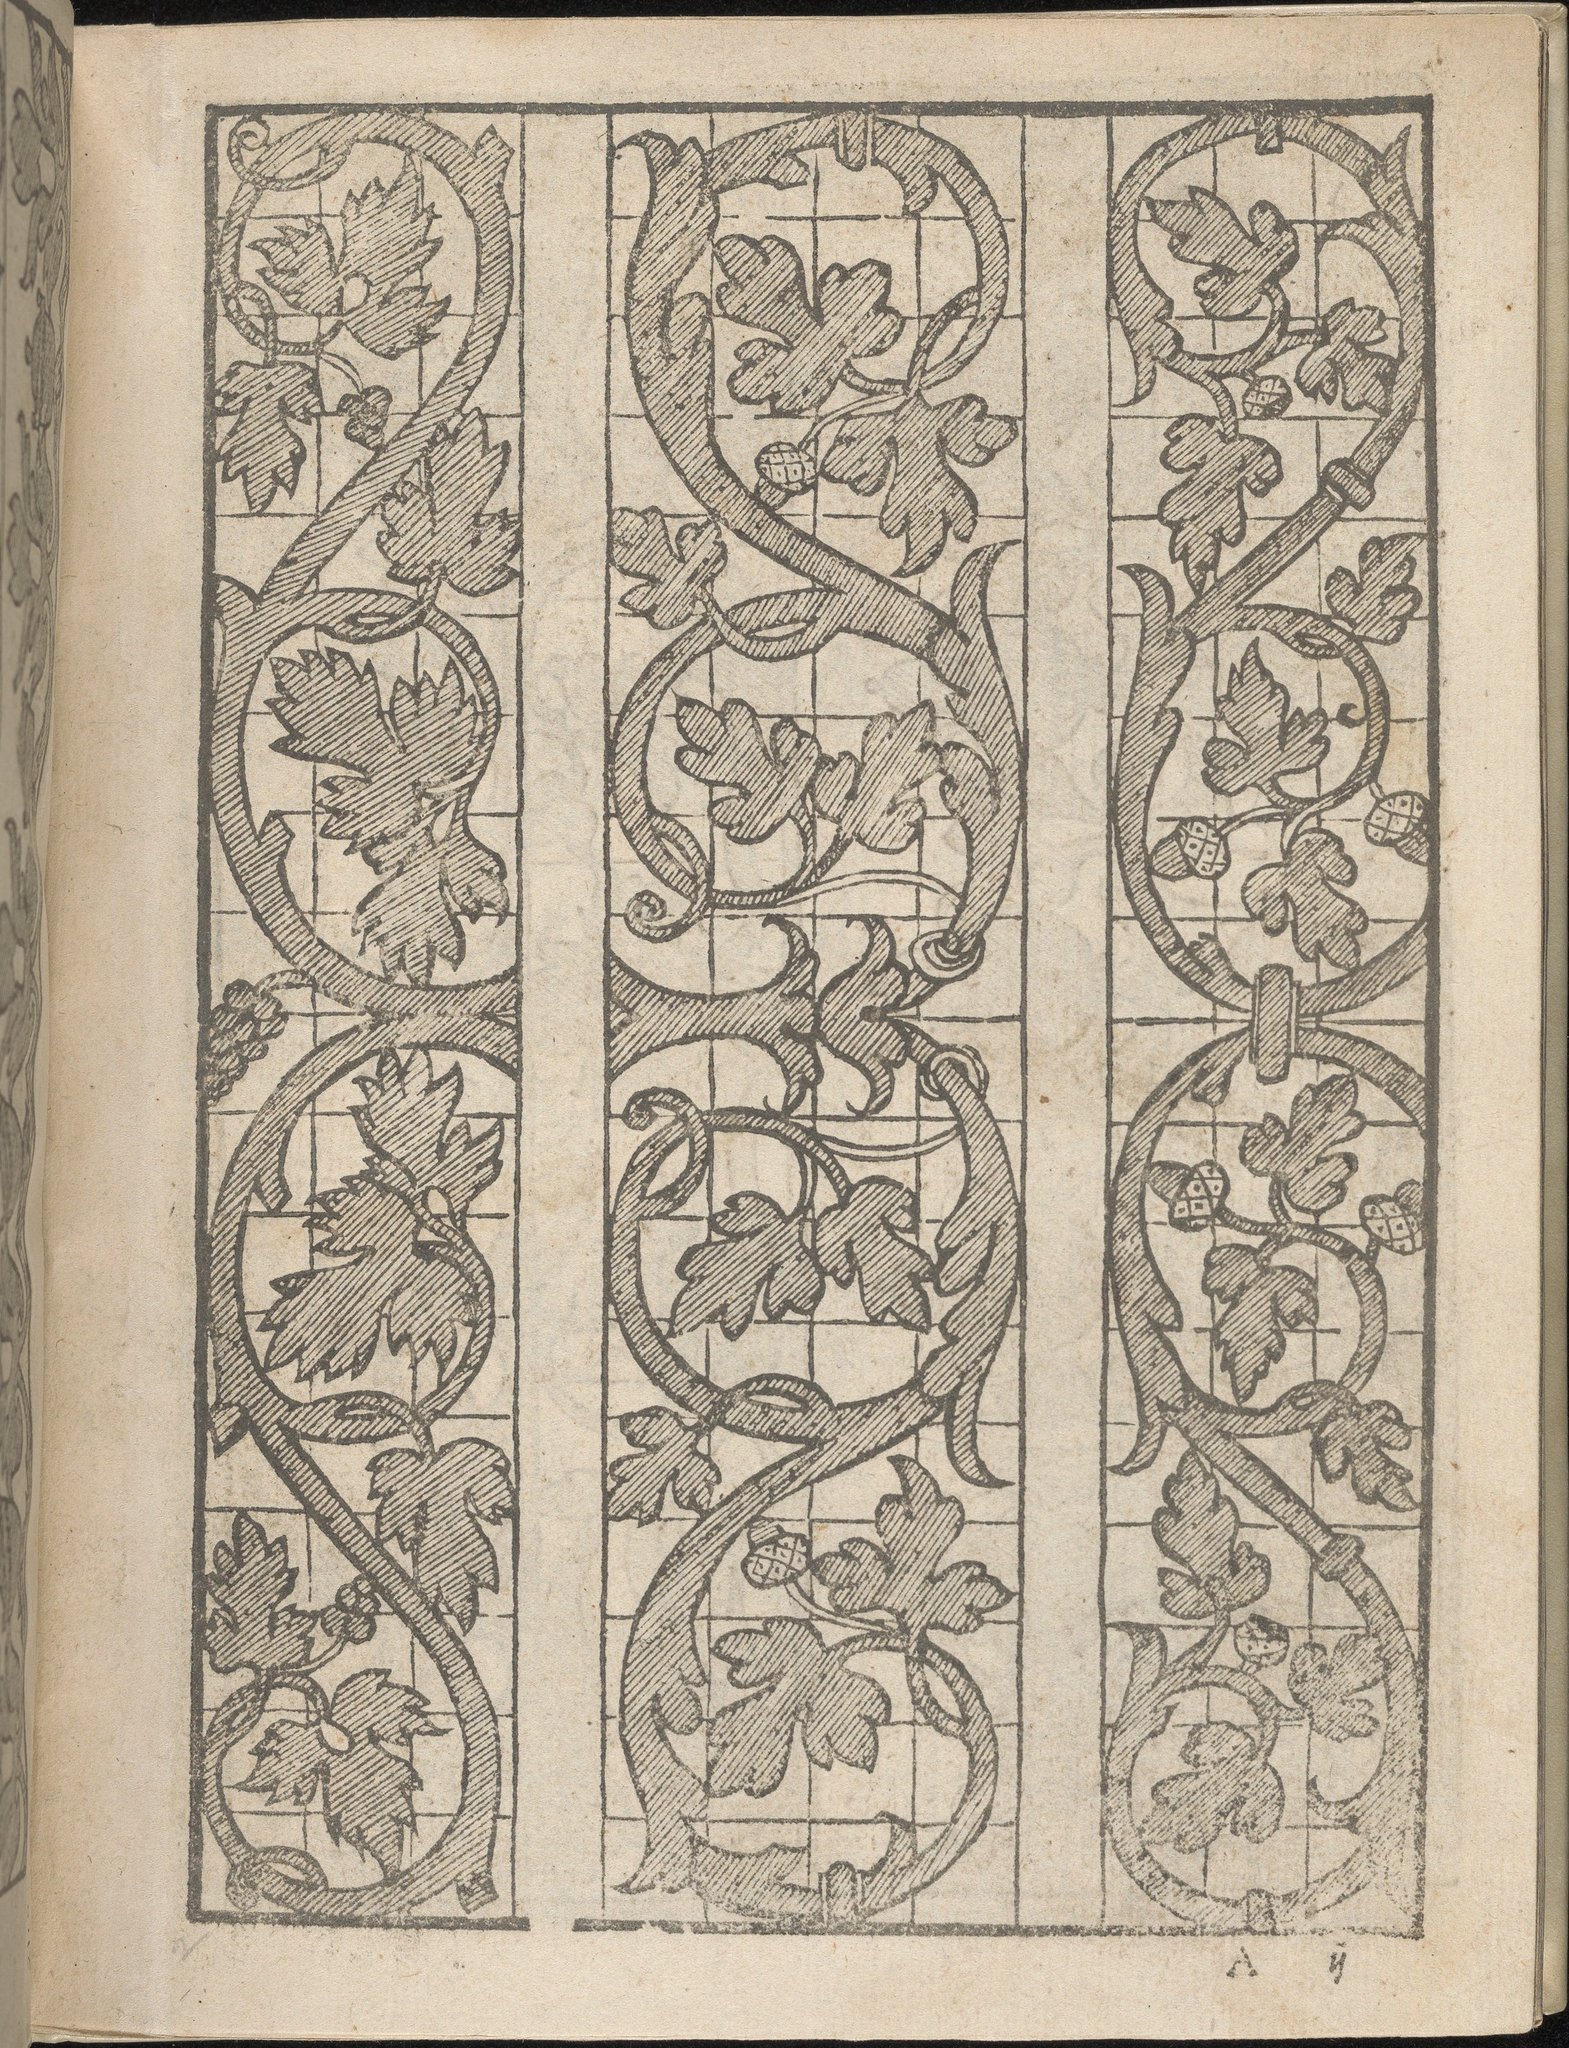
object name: book print ornament architecture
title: Lucidario di Recami, title page (verso)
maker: iseppo foresto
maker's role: designer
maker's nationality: italian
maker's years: 1520-1580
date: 1564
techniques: woodcut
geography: italy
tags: ornament